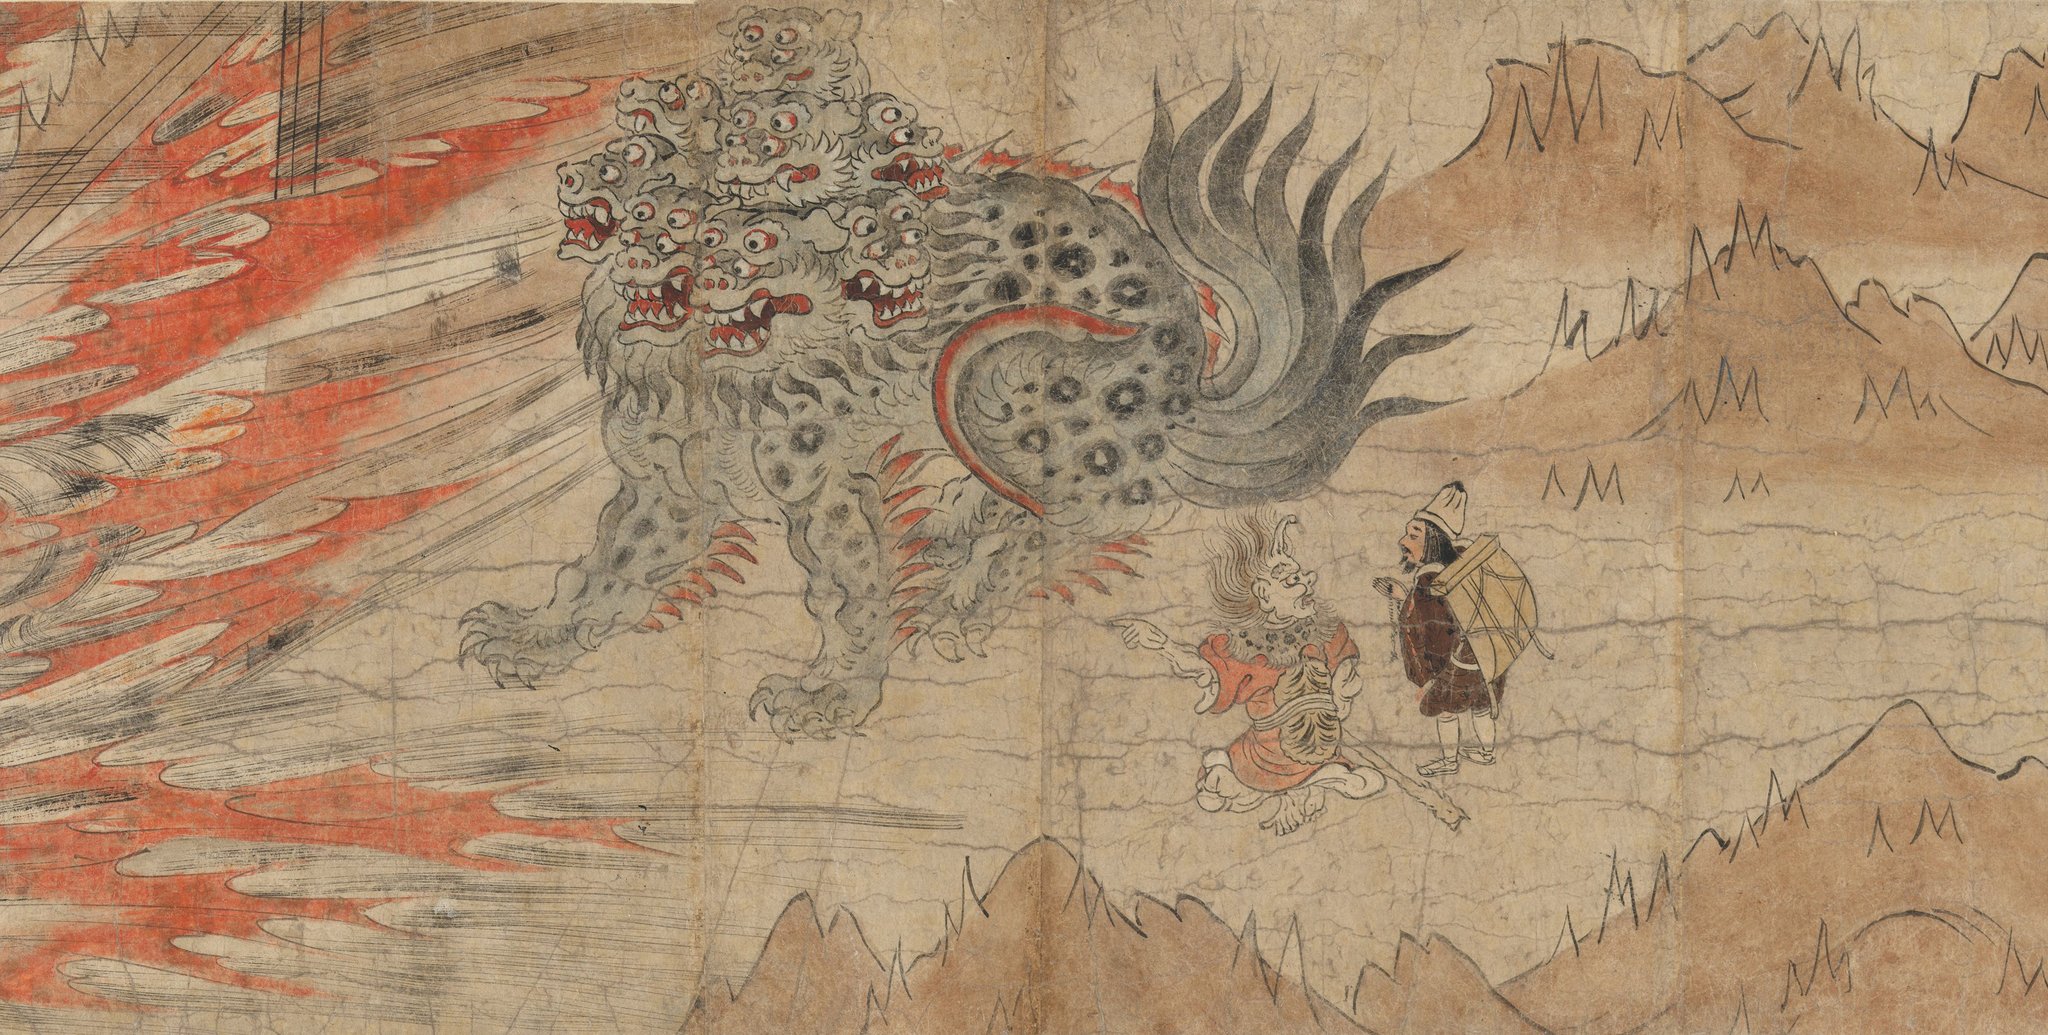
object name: handscroll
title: Illustrated Legends of the Kitano Tenjin Shrine (Kitano Tenjin engi emaki)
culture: japanese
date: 1267-1300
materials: gold leaf, ink, paper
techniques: cutting, kirikane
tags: men,mythical creatures